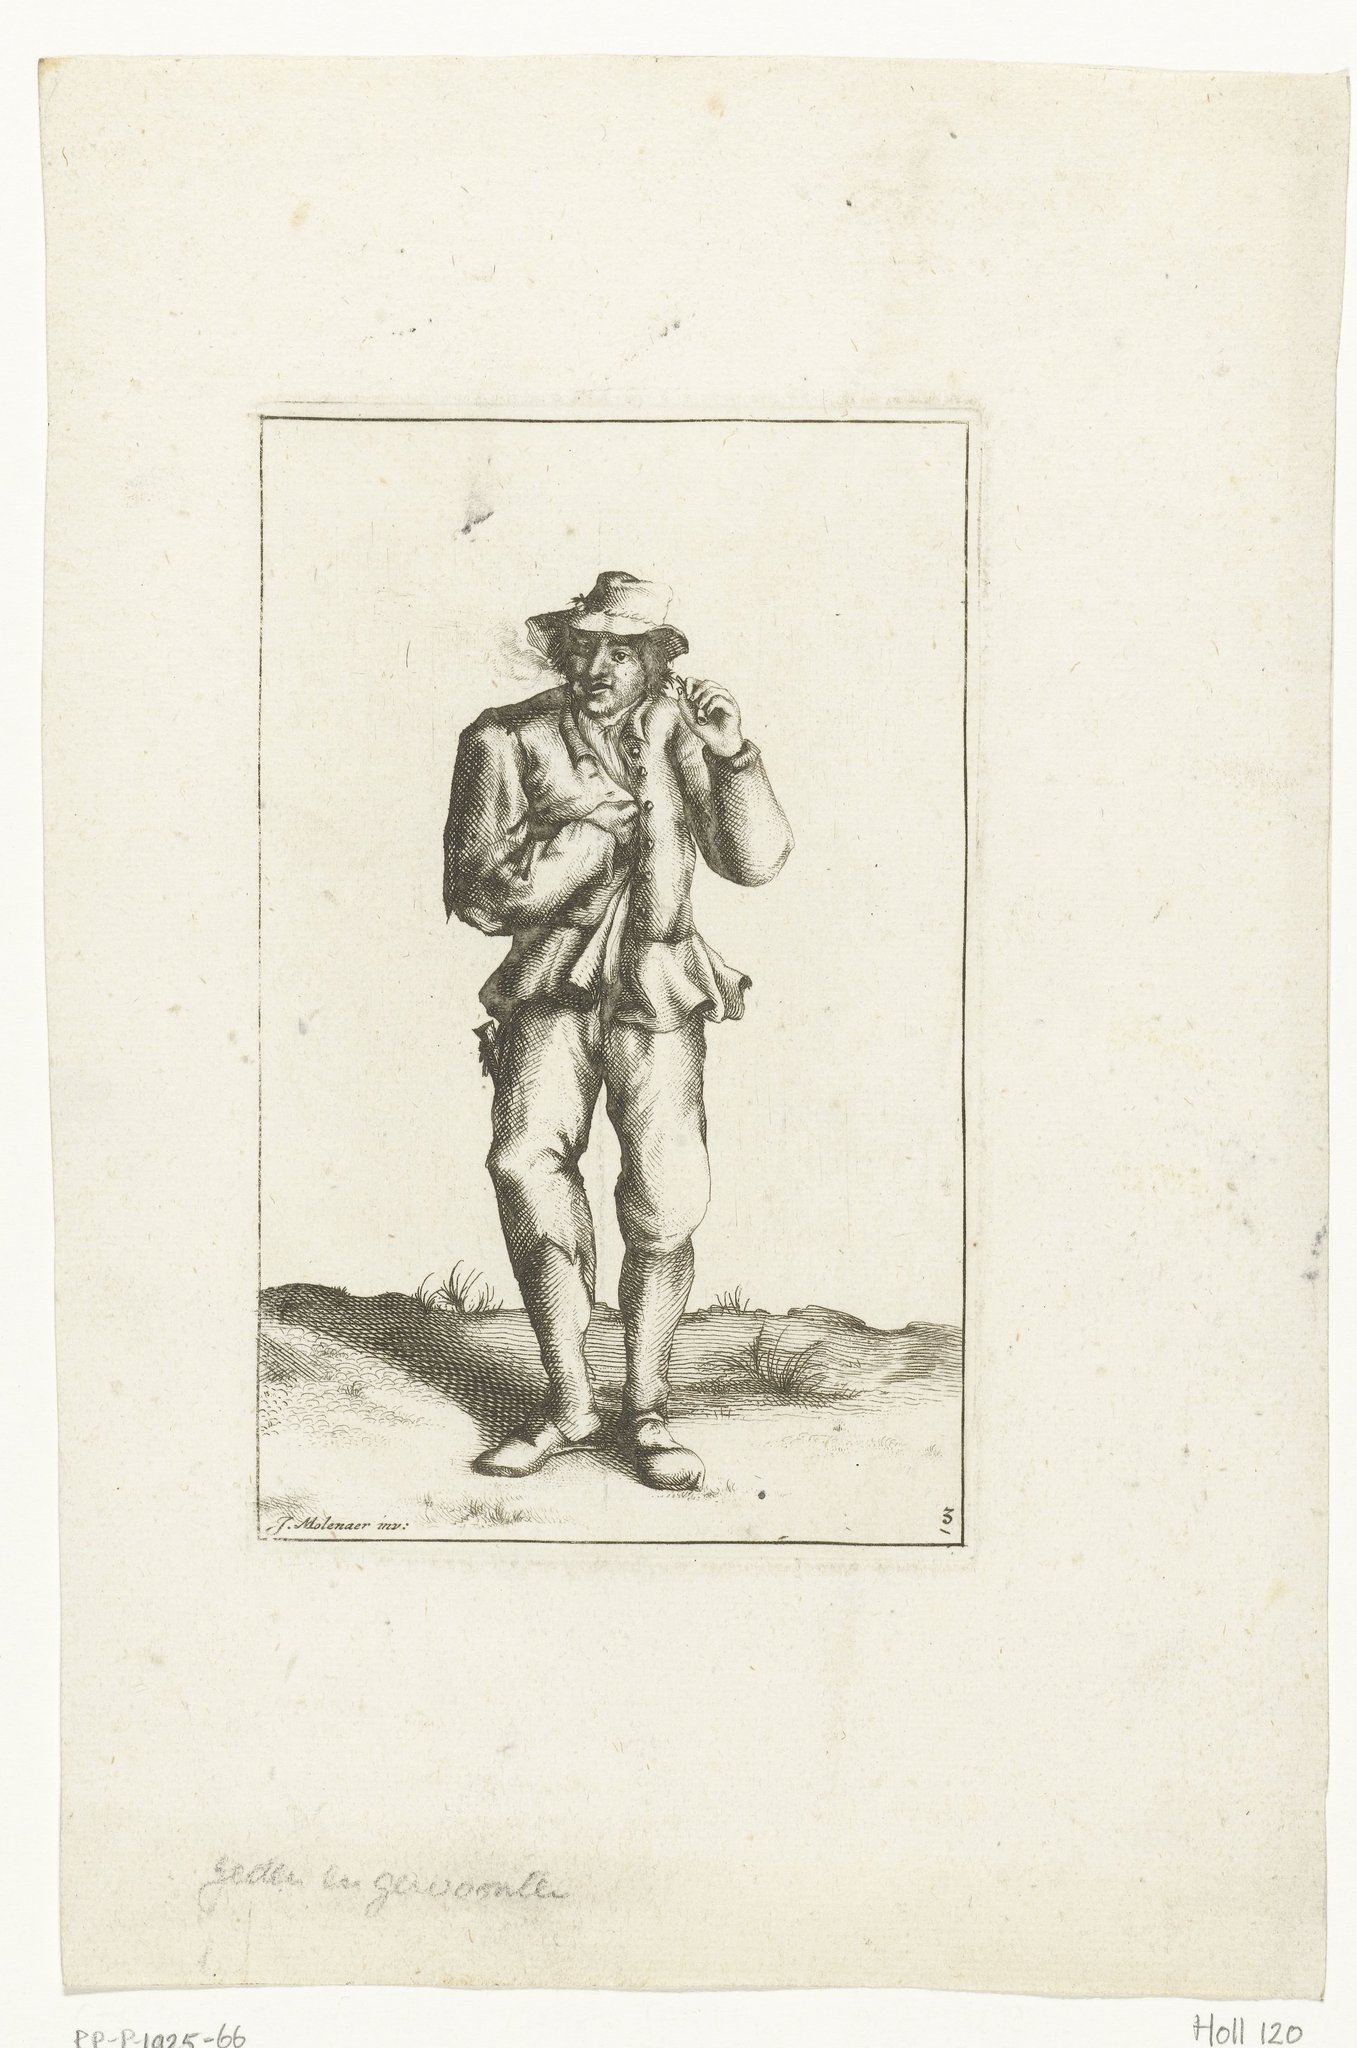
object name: print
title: Boer rookt pijp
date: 1613-1656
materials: paper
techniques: etching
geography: netherlands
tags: farmers, pipe ~ tobacco (+ taking (particular) foodstuffs: eating, drinking, smoking, chewing, etc.)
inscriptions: collector's mark: Lugt 2233, collector's mark: Lugt 2228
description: Prent uit serie van zes prenten met boeren naar verschillende kunstenaars: Jan Miense Molenaer, Pieter Quast, Hendrik Potuyl en Adriaen van Ostade.